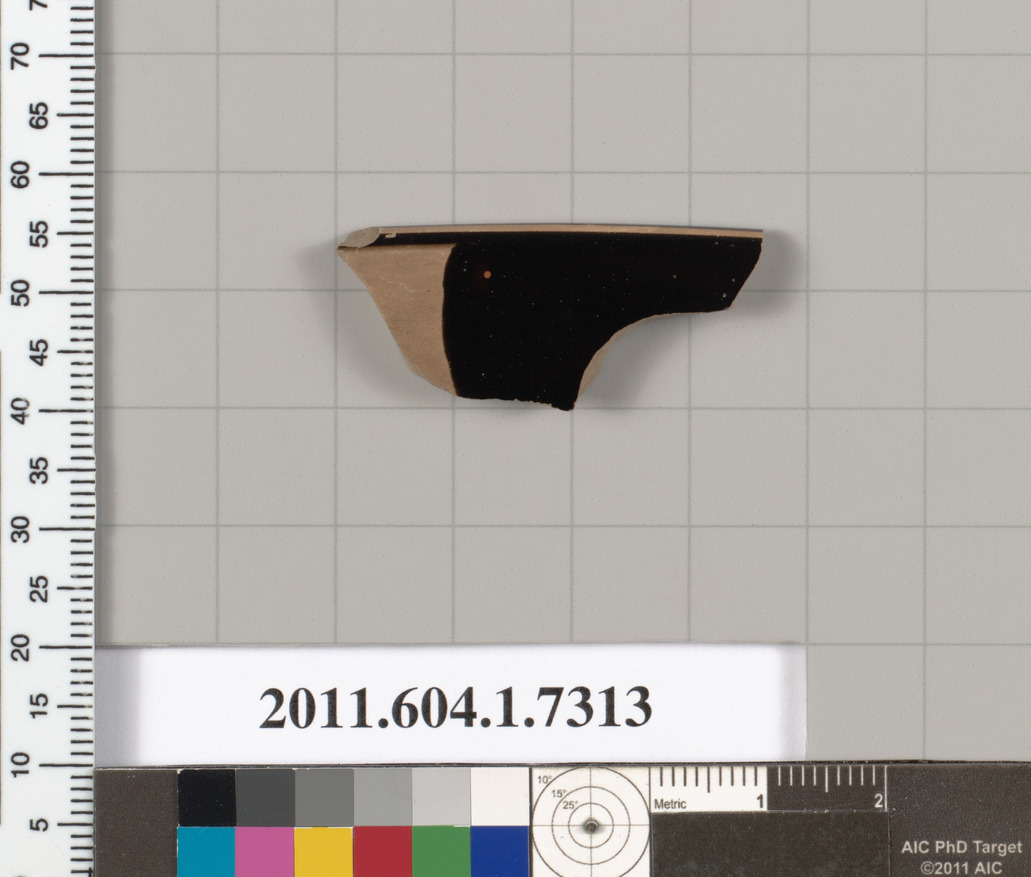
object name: kylix fragment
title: Terracotta rim fragment of a kylix (drinking cup)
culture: greek, attic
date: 500-480 BCE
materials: terracotta